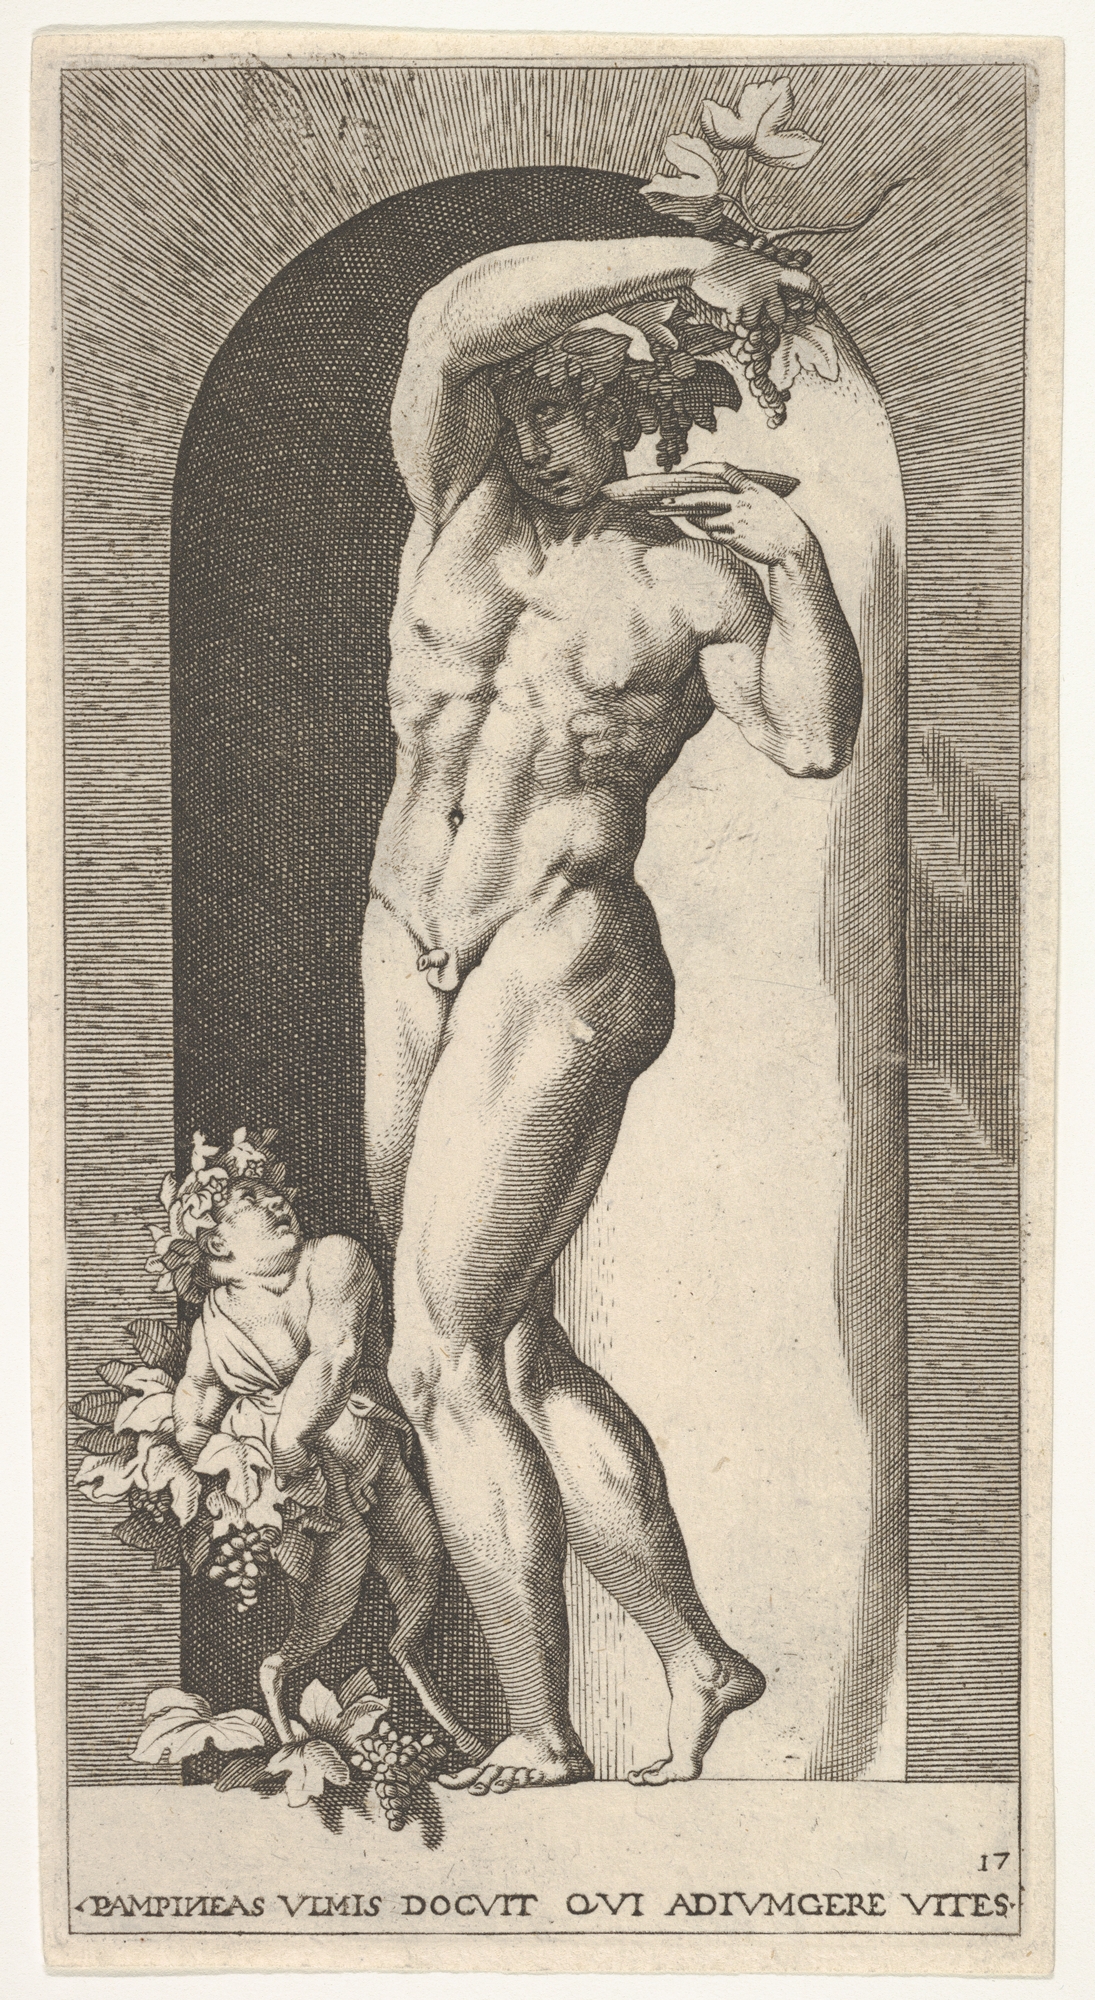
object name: print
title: Plate 17: Bacchus standing in a niche, holding grapes over a plate, accompanied by an infant satyr, from a series of mythological gods and goddesses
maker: giovanni jacopo caraglio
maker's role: artist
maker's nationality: italian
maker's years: 1500-1565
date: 1526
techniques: engraving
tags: grapes,bacchus,satyrs